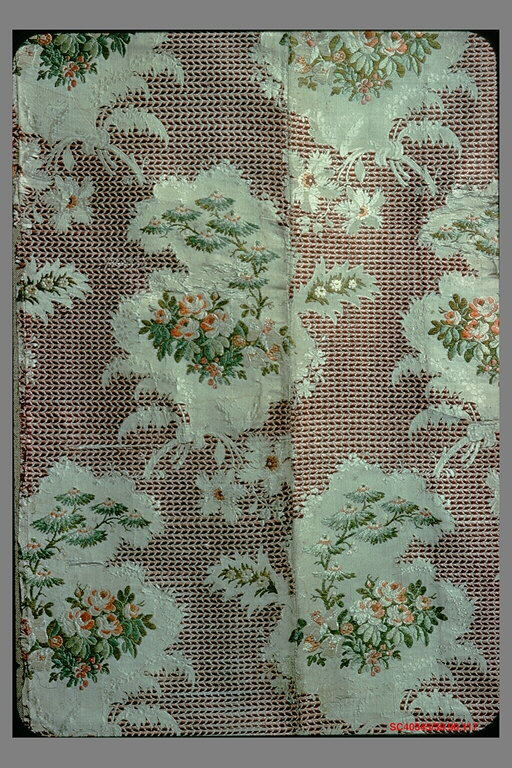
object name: piece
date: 1770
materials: silk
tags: flowers,leaves